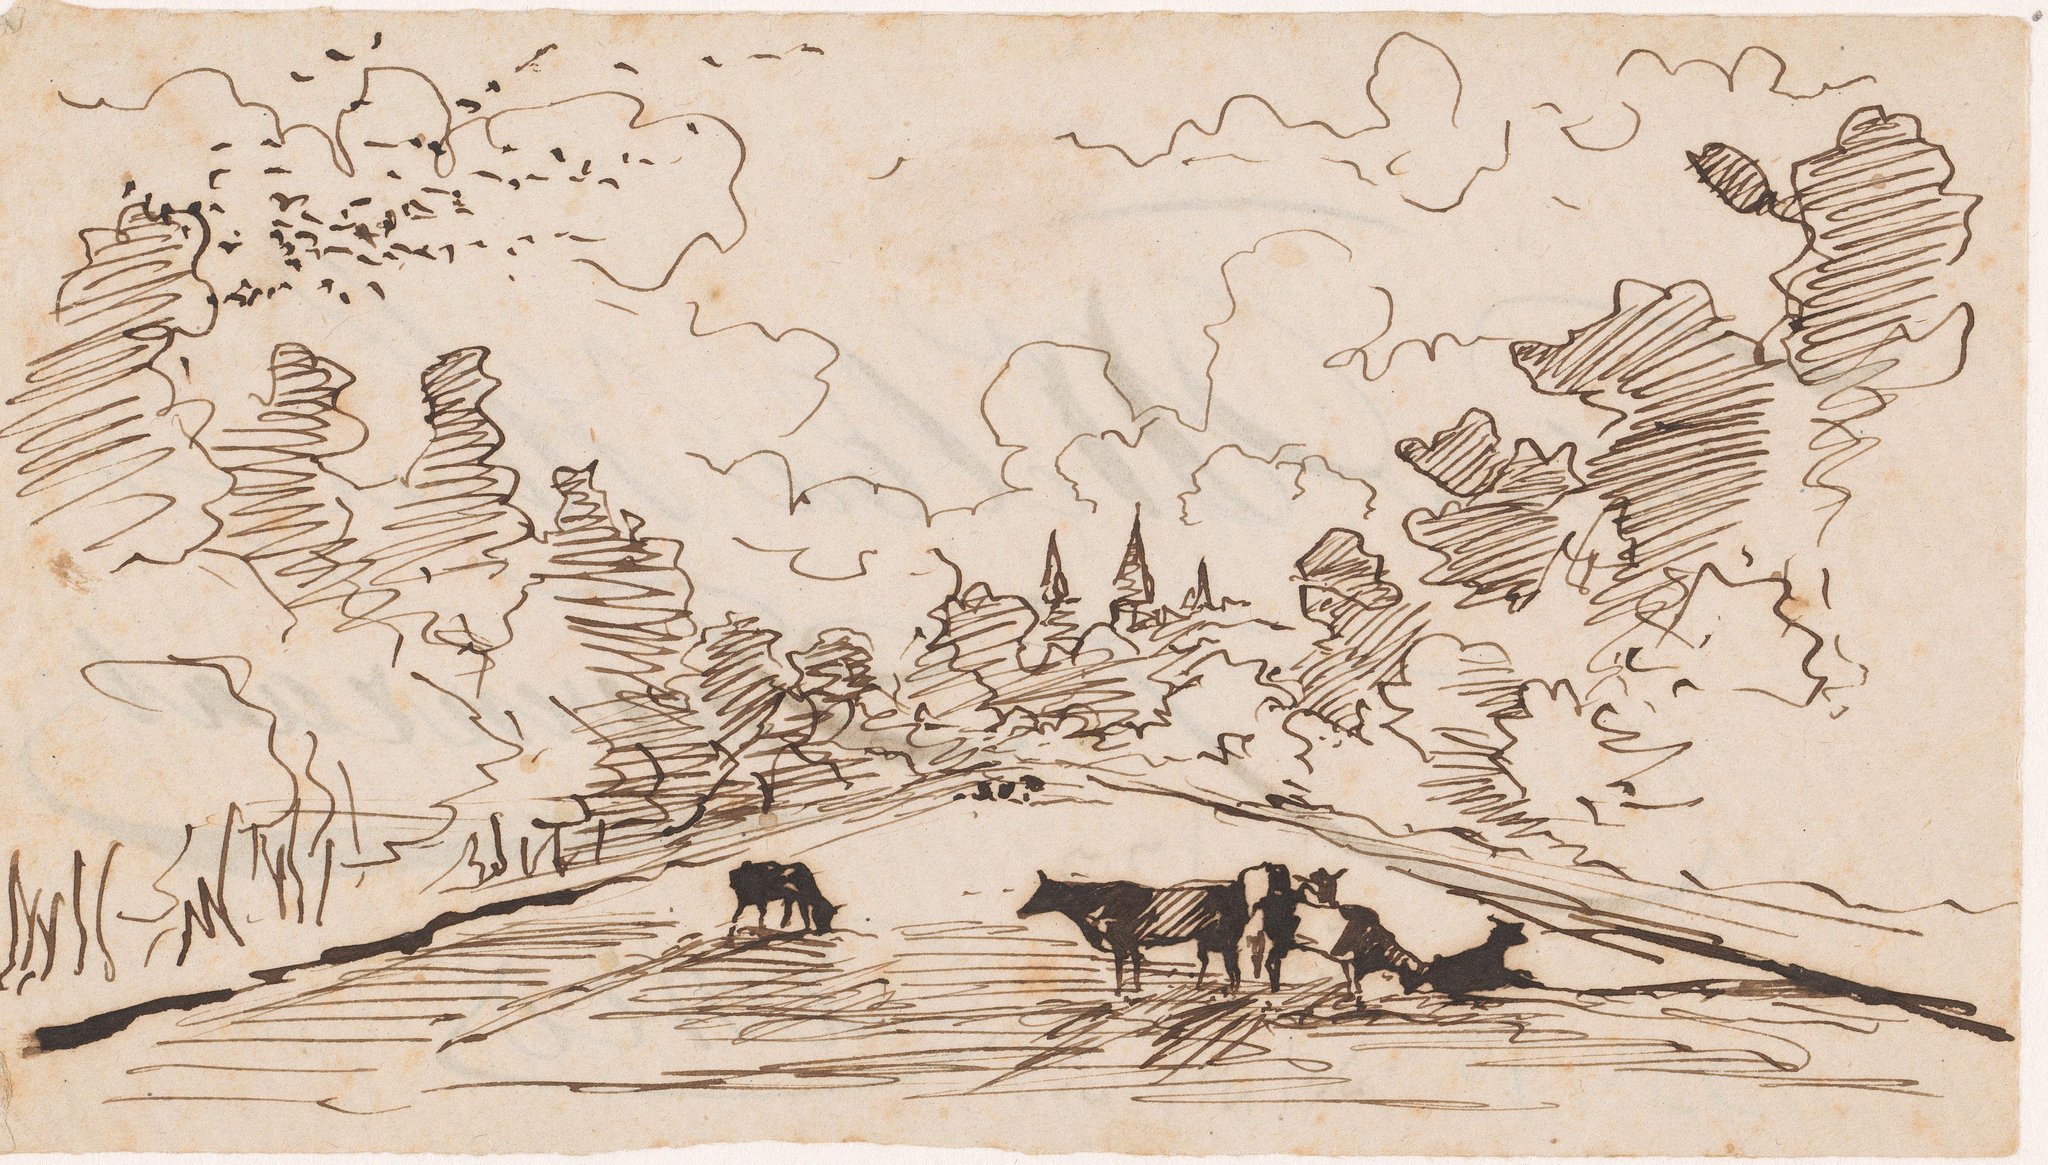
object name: drawing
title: Koeien in een landschap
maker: johannes tavenraat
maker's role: draughtsman, painter, print maker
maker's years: 1809-1881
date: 1819-1881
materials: ink, paper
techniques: pen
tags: cow, meadow, pasture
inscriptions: annotation: ‘Den WelEd. Heer J. Tavenraat’